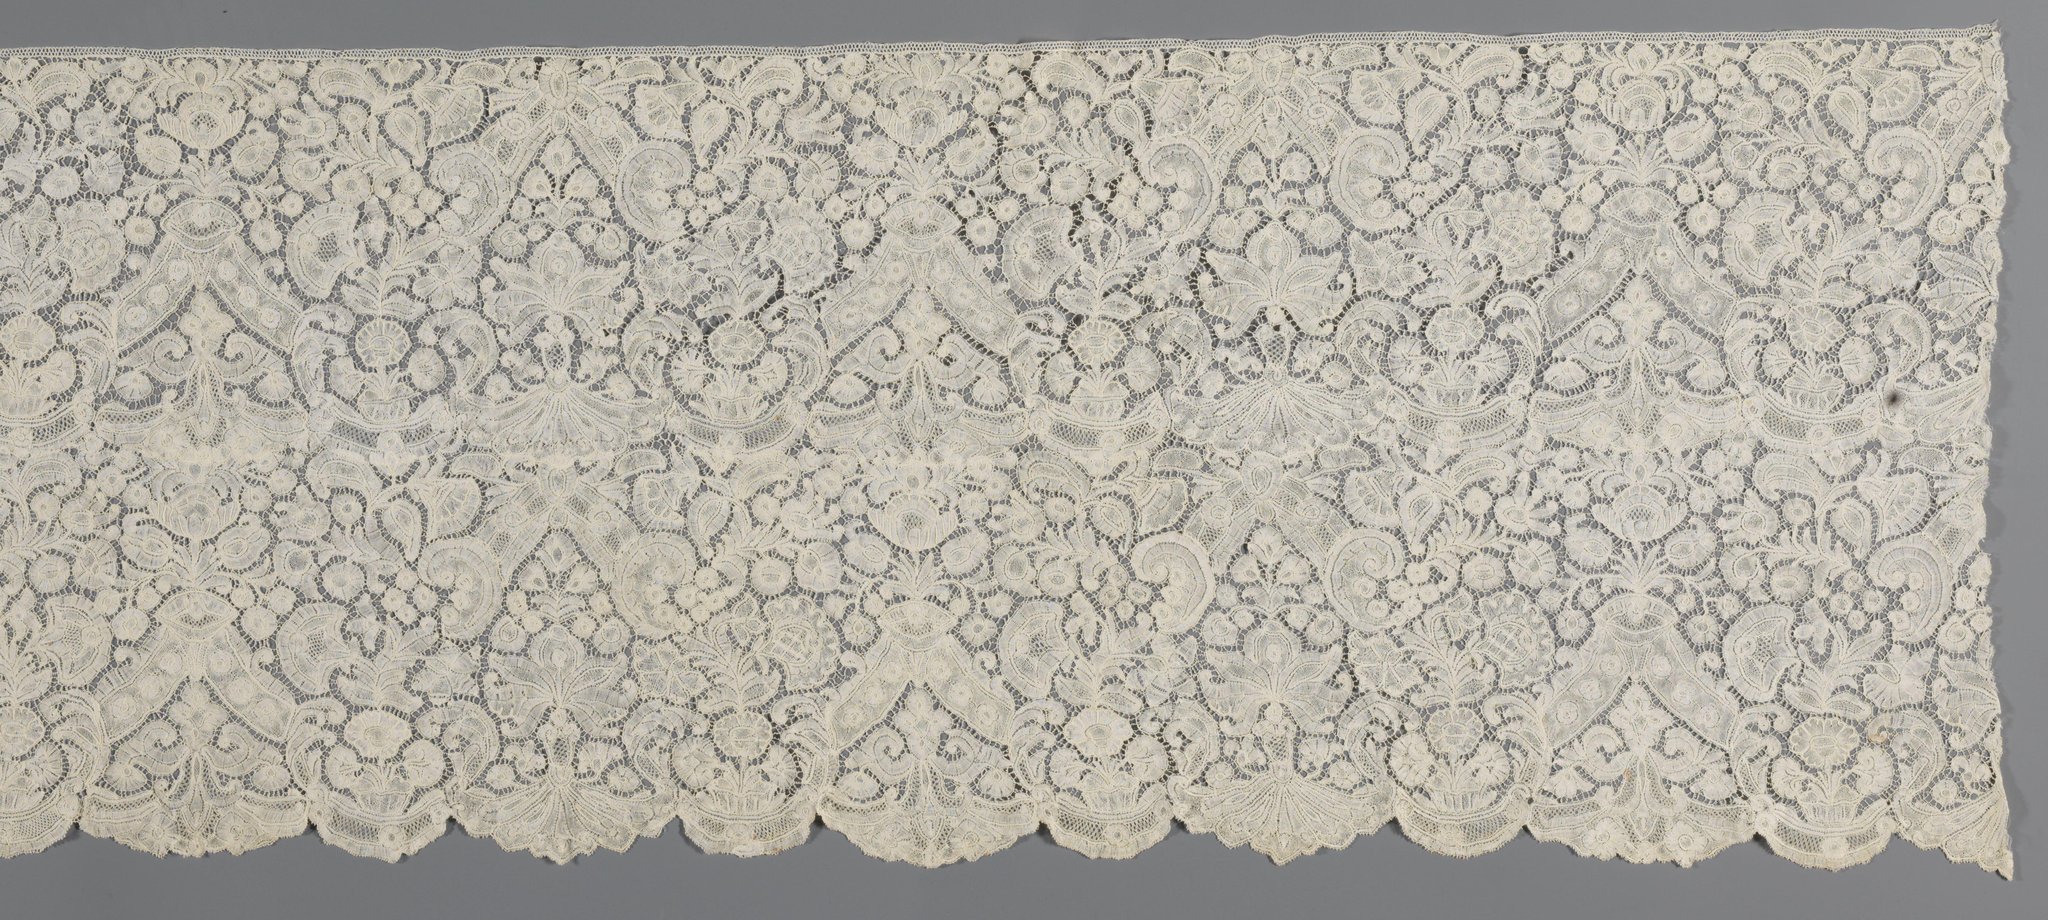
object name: albestrook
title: Albestrook van kloskant met bloemen in spitsboog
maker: Anonymous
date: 1725-1735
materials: linen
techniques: lace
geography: southern netherlands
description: Albestrook van naturelkleurige kloskant: oude Brabantse kant. Twee bijna symmetrische motieven wisselen elkaar af. I. Een palmetbloem en een waaiervormige bladrozet staan onder een hoge spitsboog. II. Een kleine fleur de lys staat onder een lage spitsboog. In de schulpen komt bandwerk voor van liggende c-voluten, die telkens een bloemenmand omvatten. Hieruit ontspringt een grote tak met geverderd blad en zeer grote bloemen. Tussen het gesloten ornament is weinig plaats gelaten voor smalle strookjes van een open vlechtengrond.